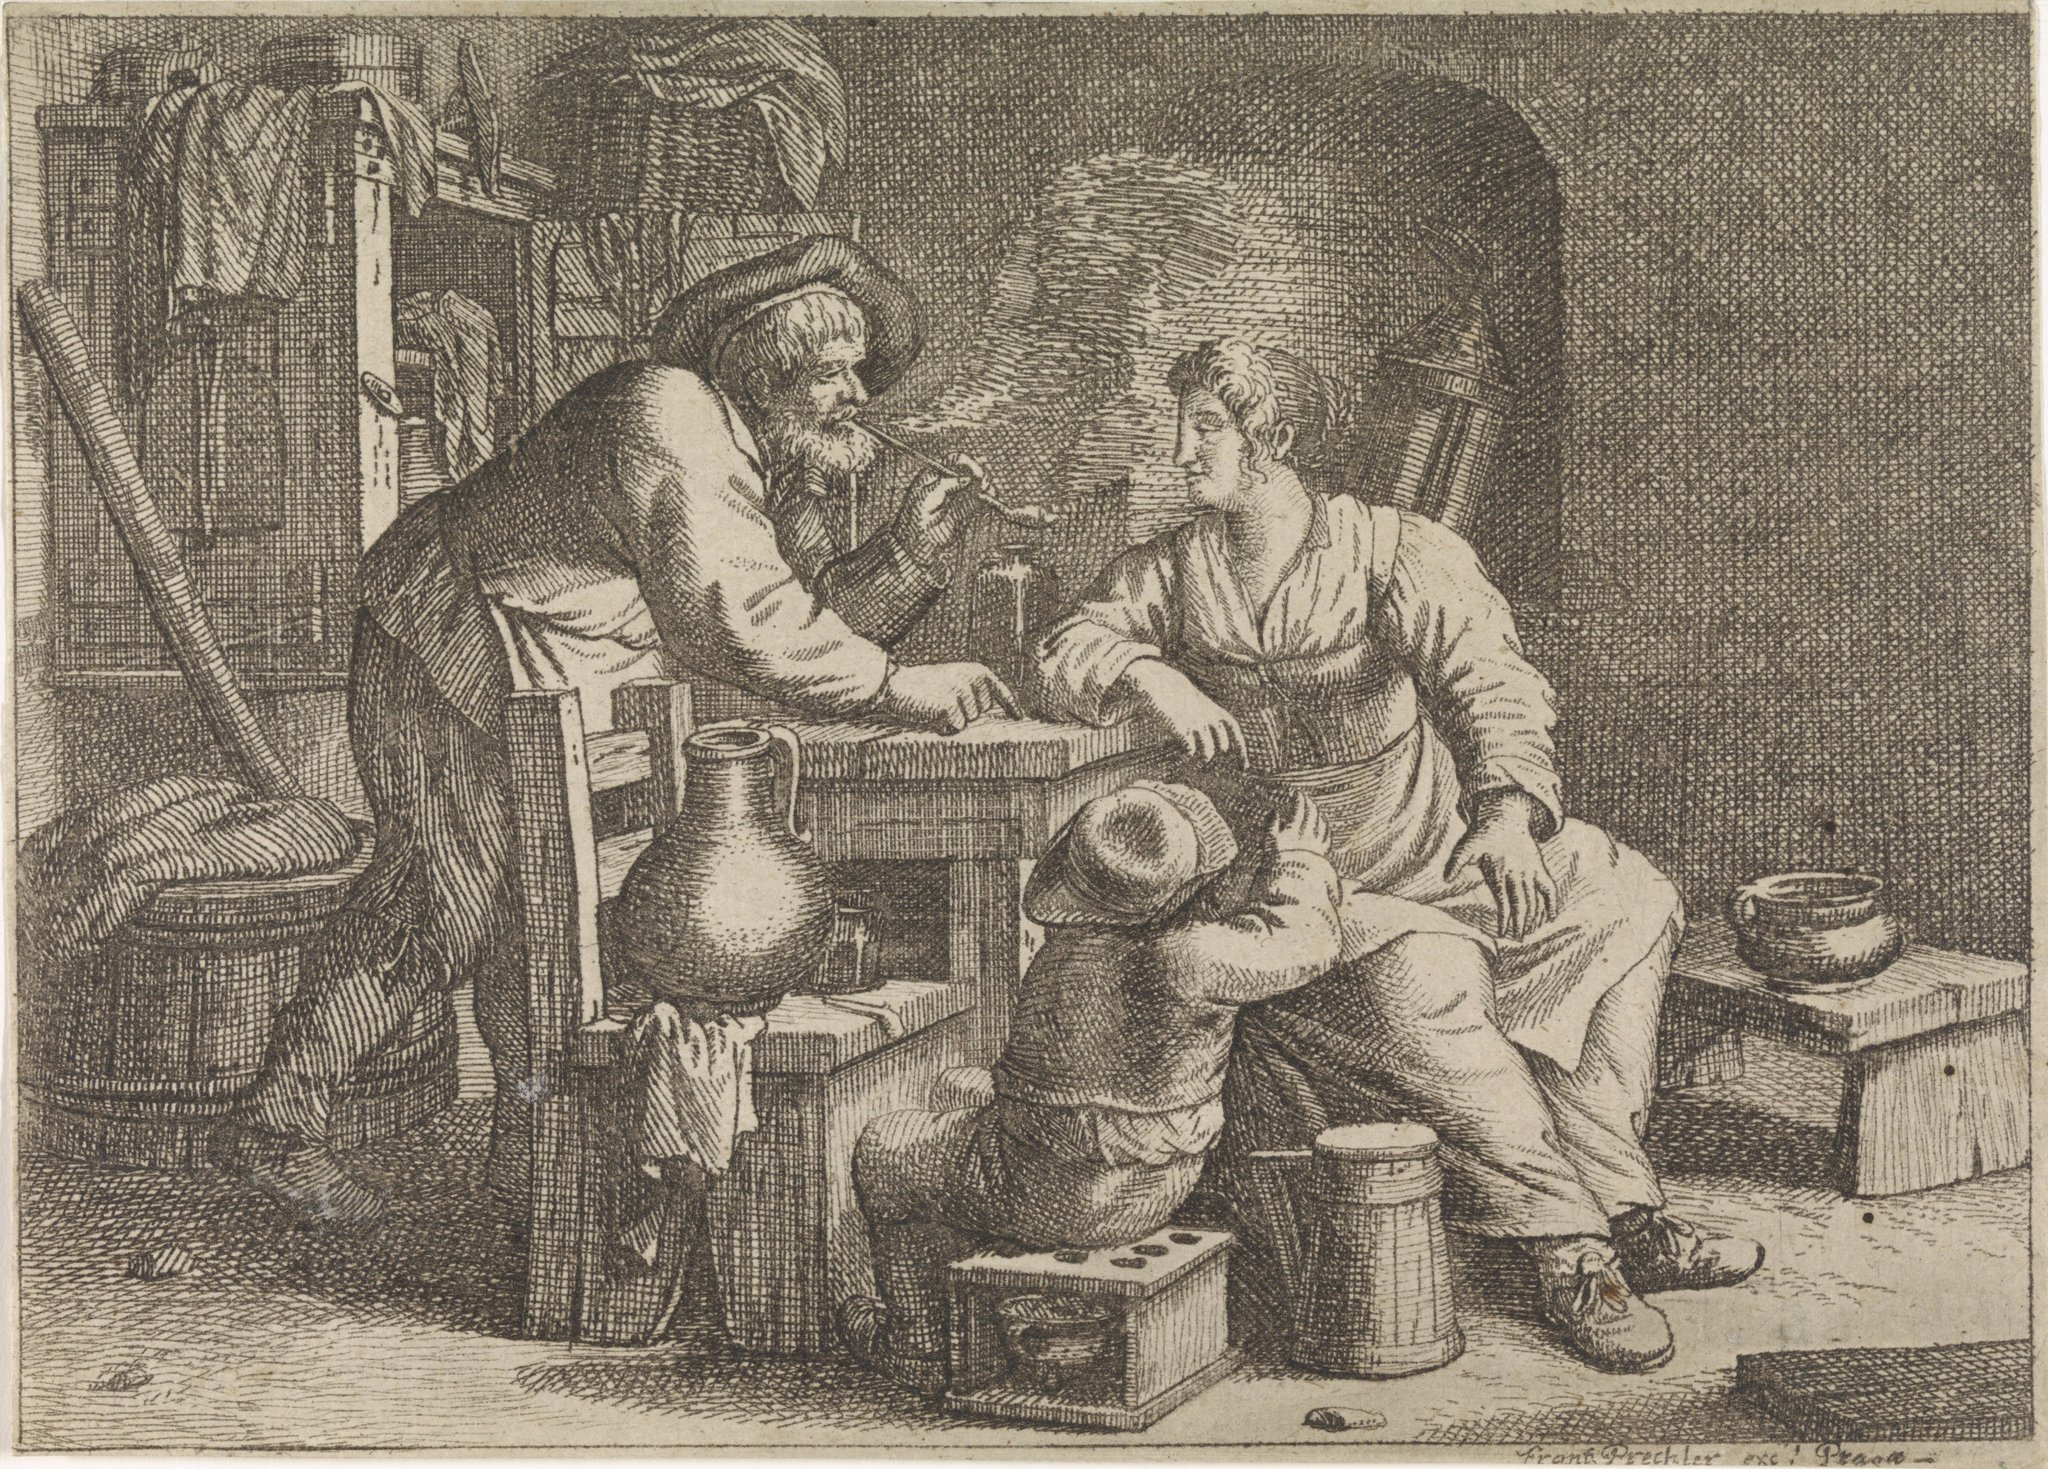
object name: print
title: Interieur met een rokende boer, een vrouw en een jongen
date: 1635-1692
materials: paper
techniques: engraving, etching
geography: prague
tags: foot-stove, pipe ~ tobacco, farmers, farm (building) - aa - civic architecture: inside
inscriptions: collector's mark: Lugt 2165, collector's mark: Lugt 90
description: Een boer, met een baret op het hoofd en die een pijp rookt, leunt over een tafel. Aan de andere kant van de tafel zit een vrouw, die naar de boer kijkt. Naast haar zit een jongen op een stoof. Linksachter staat een houten kast open.